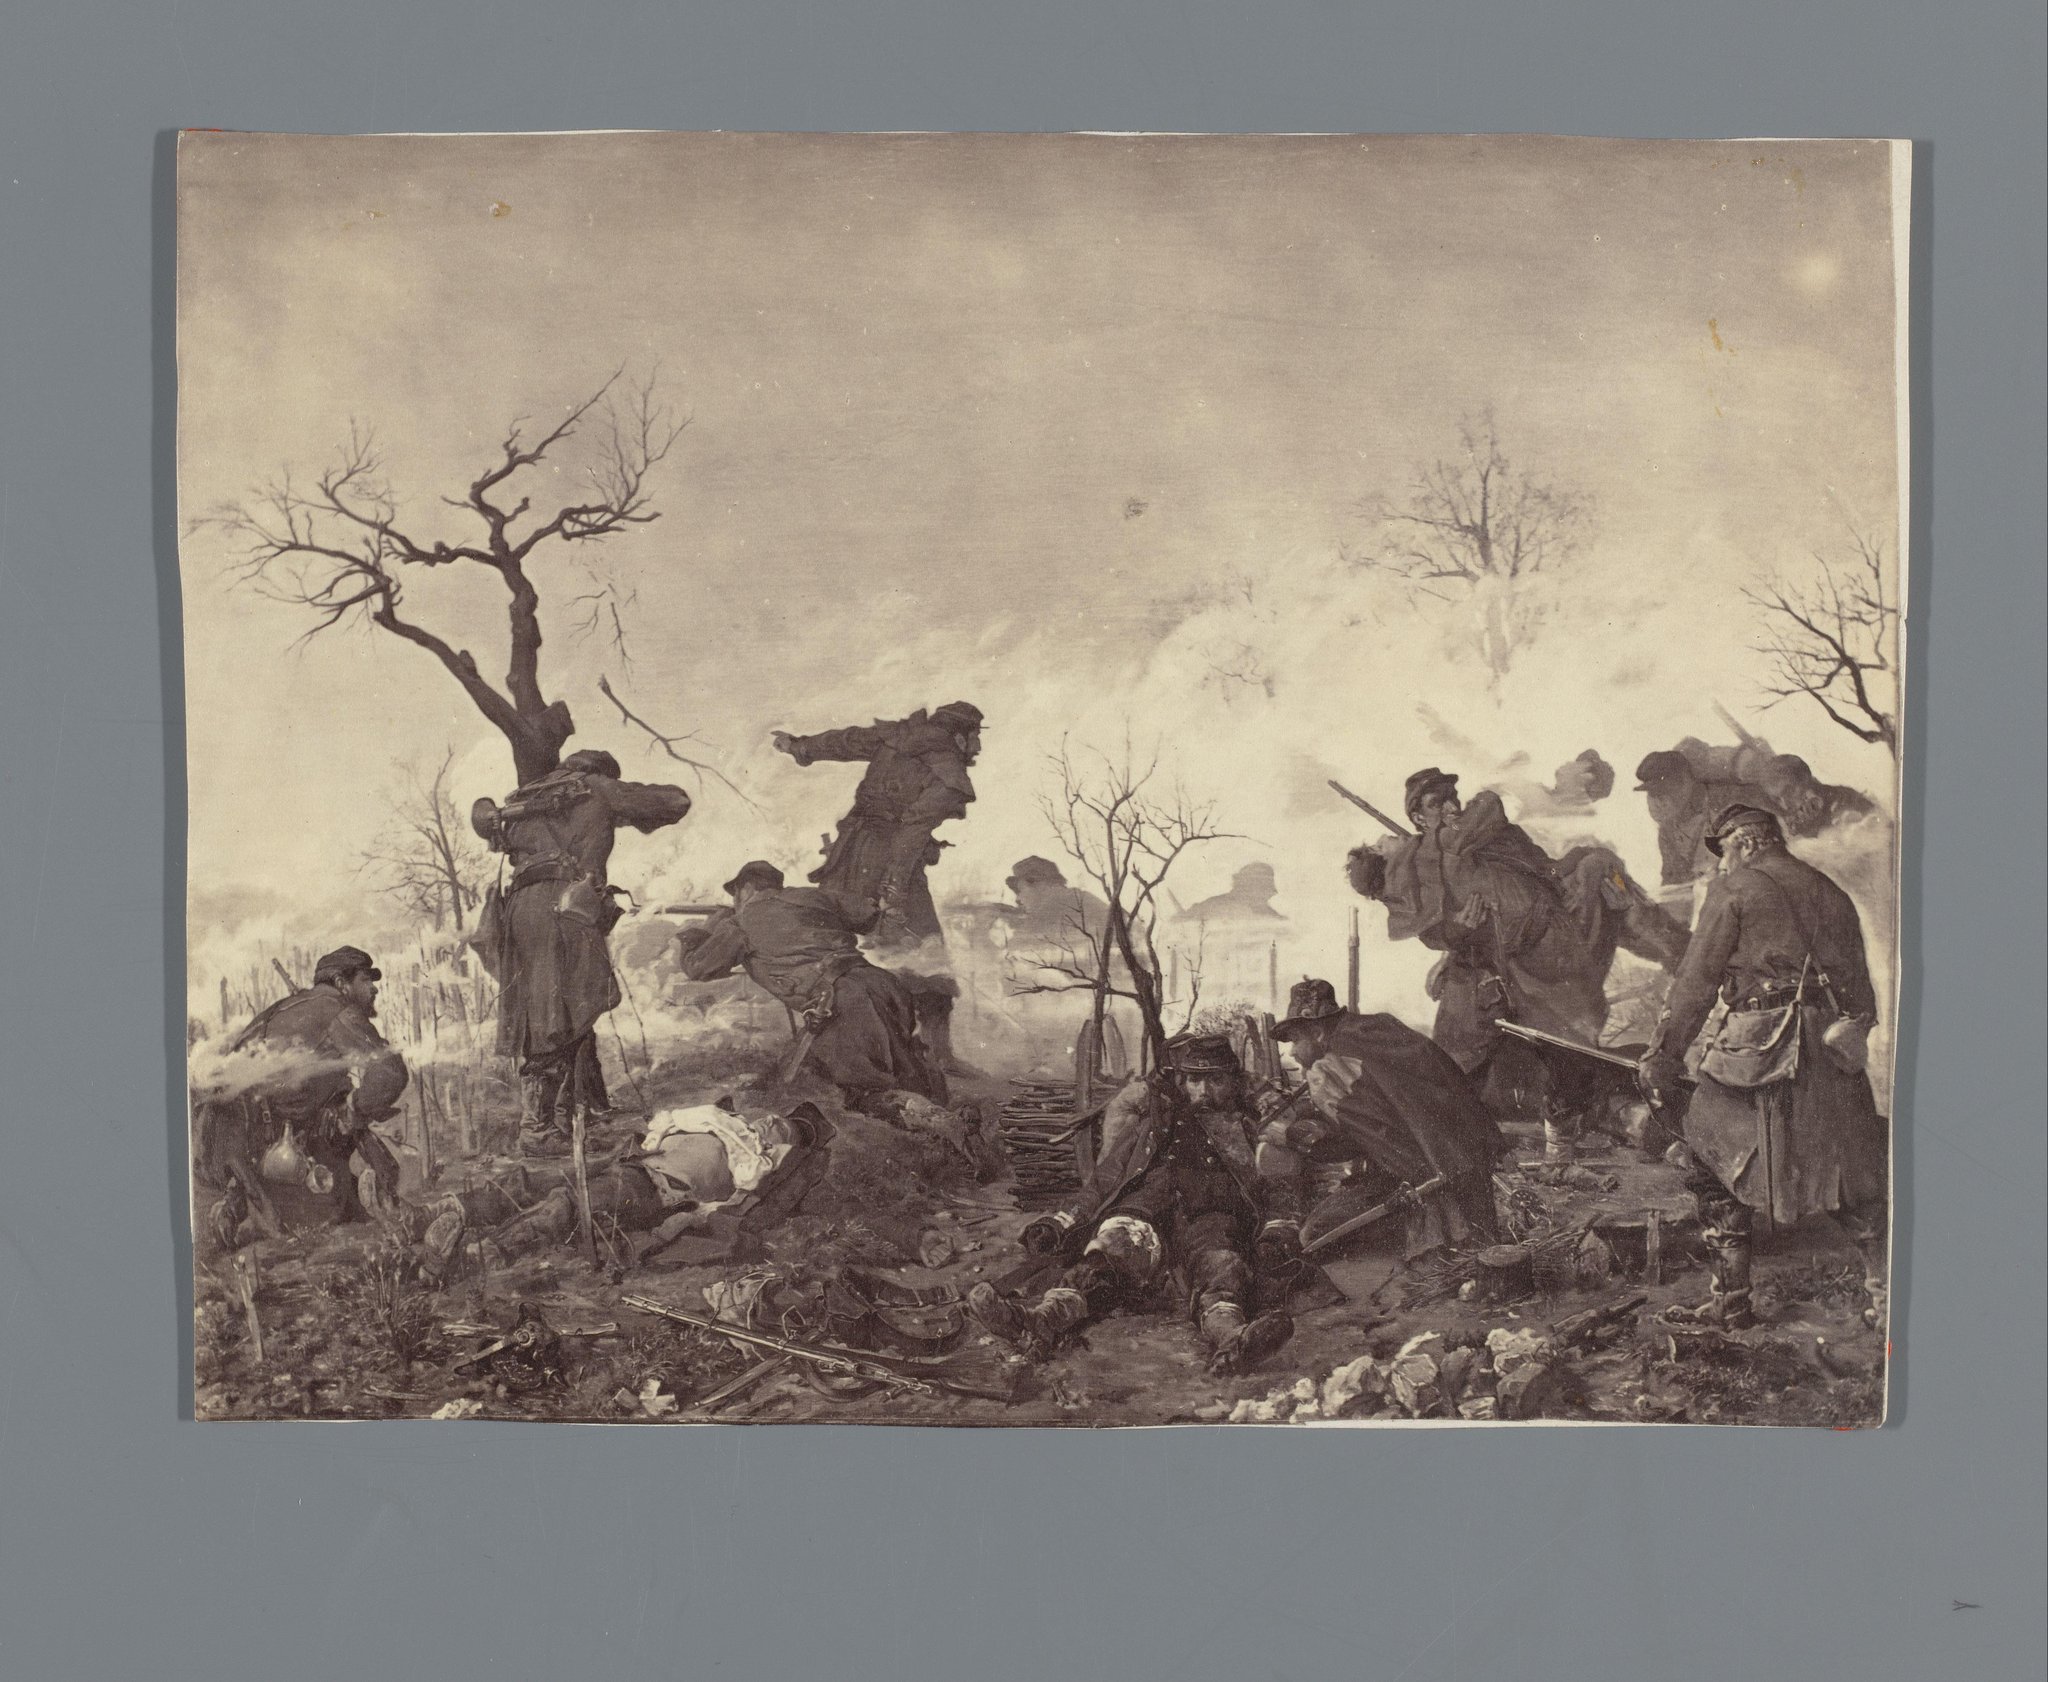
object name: reproduction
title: Fotoreproductie van (vermoedelijk) een schilderij van een veldslag van Franse soldaten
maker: Anonymous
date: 1880-1900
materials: paper, photographic support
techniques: albumen print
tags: battle